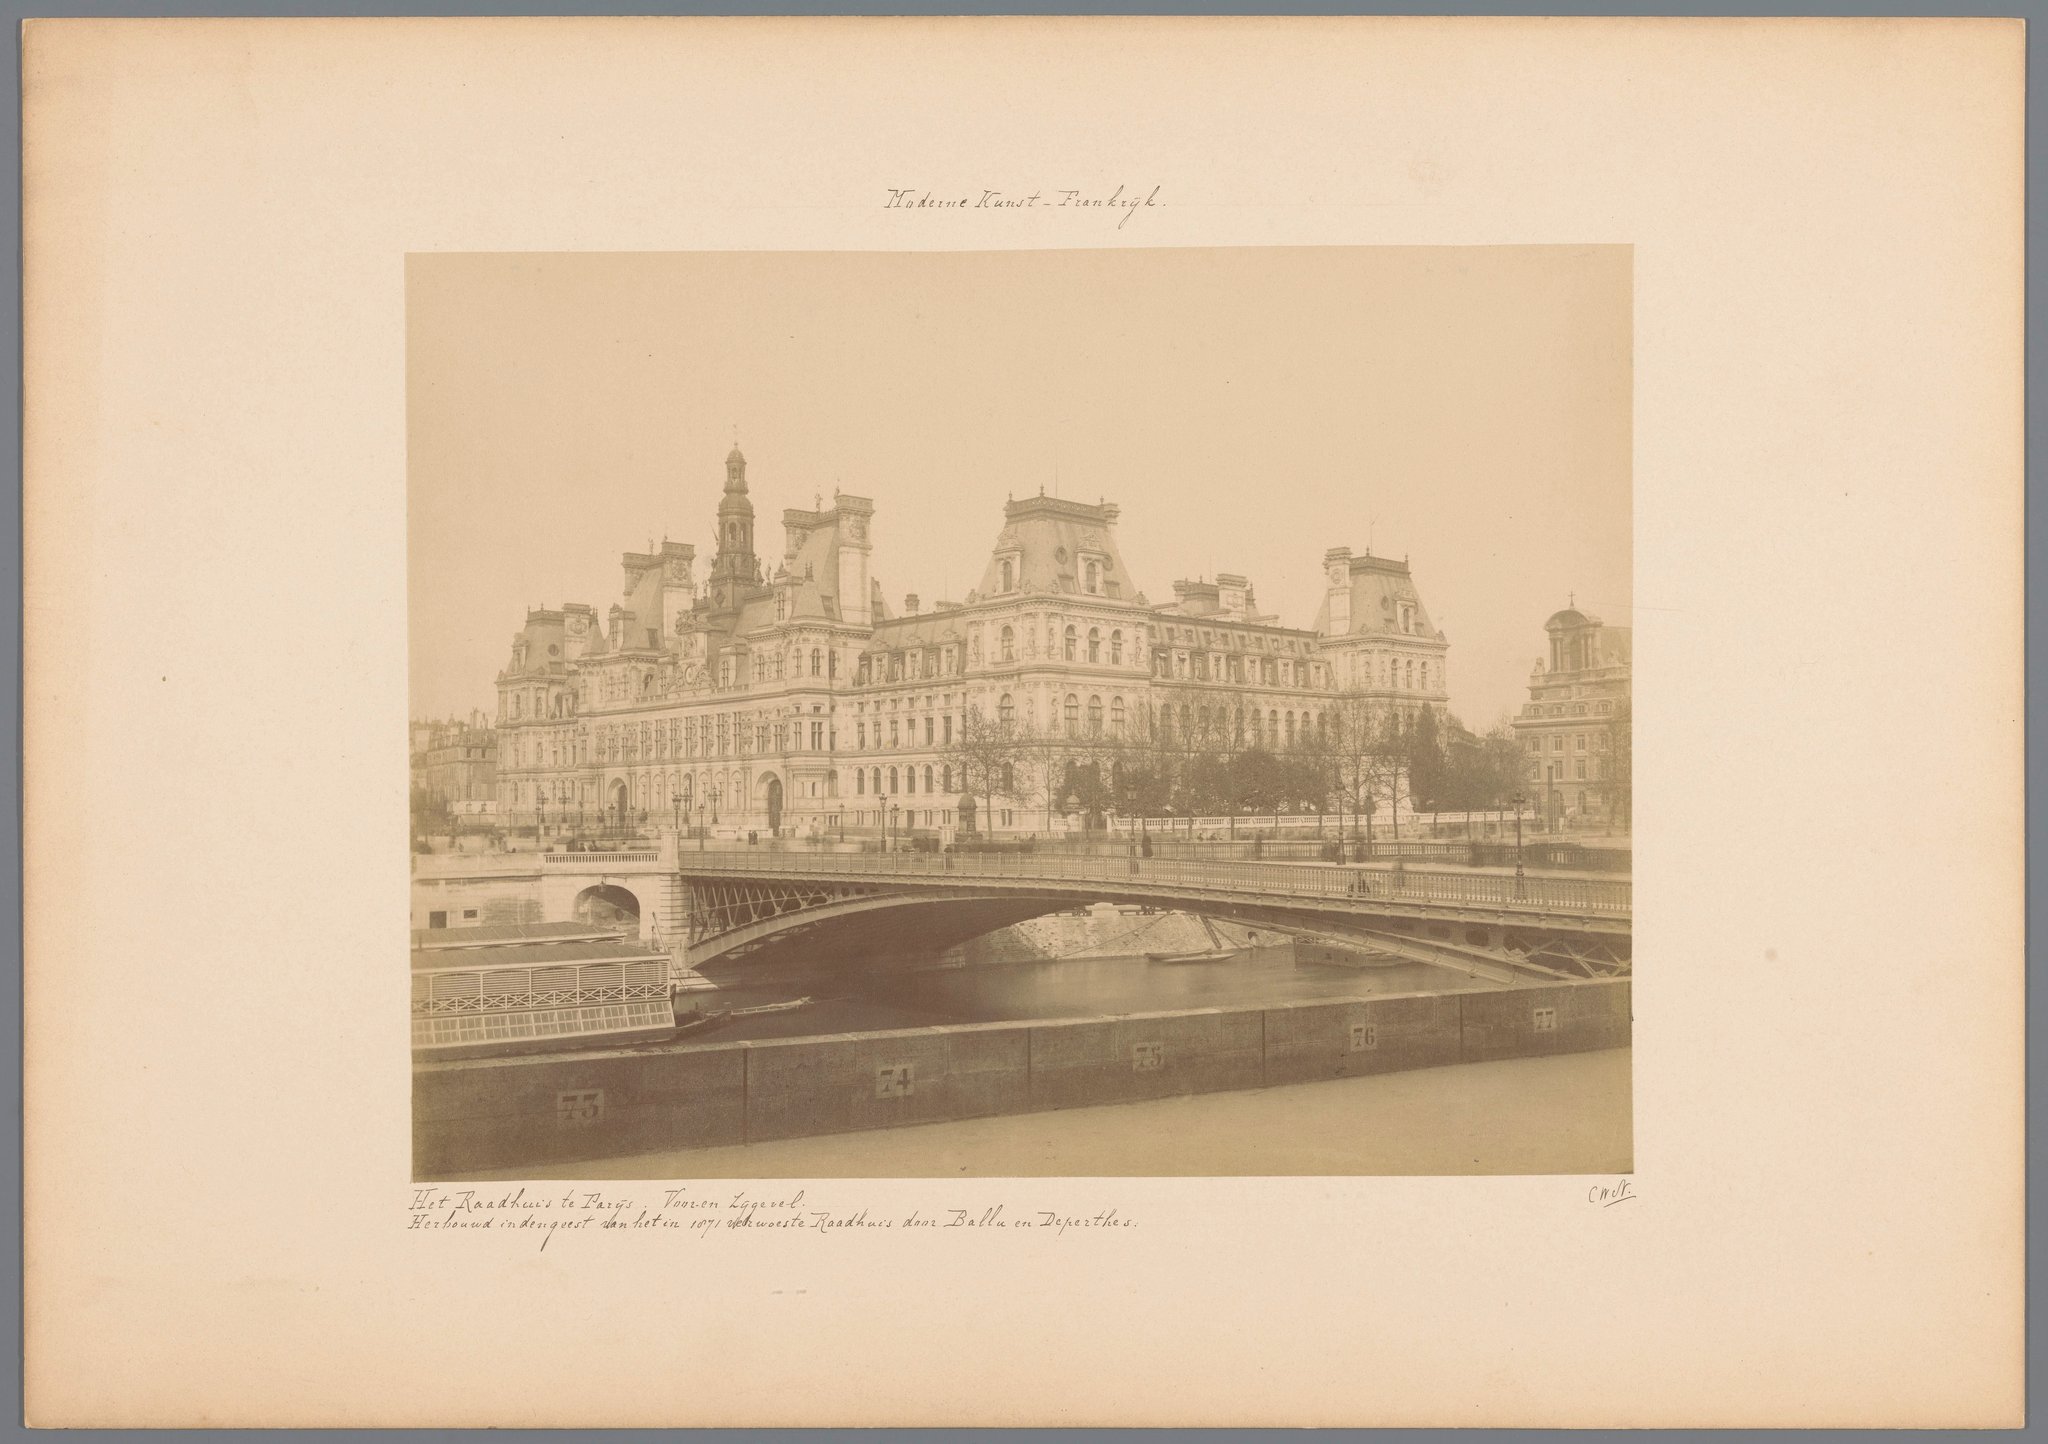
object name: photograph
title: Gezicht op het stadhuis van Parijs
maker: Anonymous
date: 1892-1900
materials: cardboard, photographic support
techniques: albumen print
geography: paris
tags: river, townhall, façade (of house or building), bridge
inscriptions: inscription: ‘CWN.’, inscription: ‘Moderne Kunst - Frankrijk. Het Raadhuis te Parijs (...) Herbouwd in den geest van het in 1871 verwoeste Raadhuis door Ballu en Deperthes.’, collector's mark: ‘KUNSTNIJVERHEIDSCHOOL QUELLINUS AMSTERDAM FRANS HALSSTRAAT 14.’, collector's mark: ‘INSTITUUT VOOR KUNST- NIJVERHEIDSONDERWIJS GABRIËL METSUSTRAAT No. 16. AMSTERDAM’